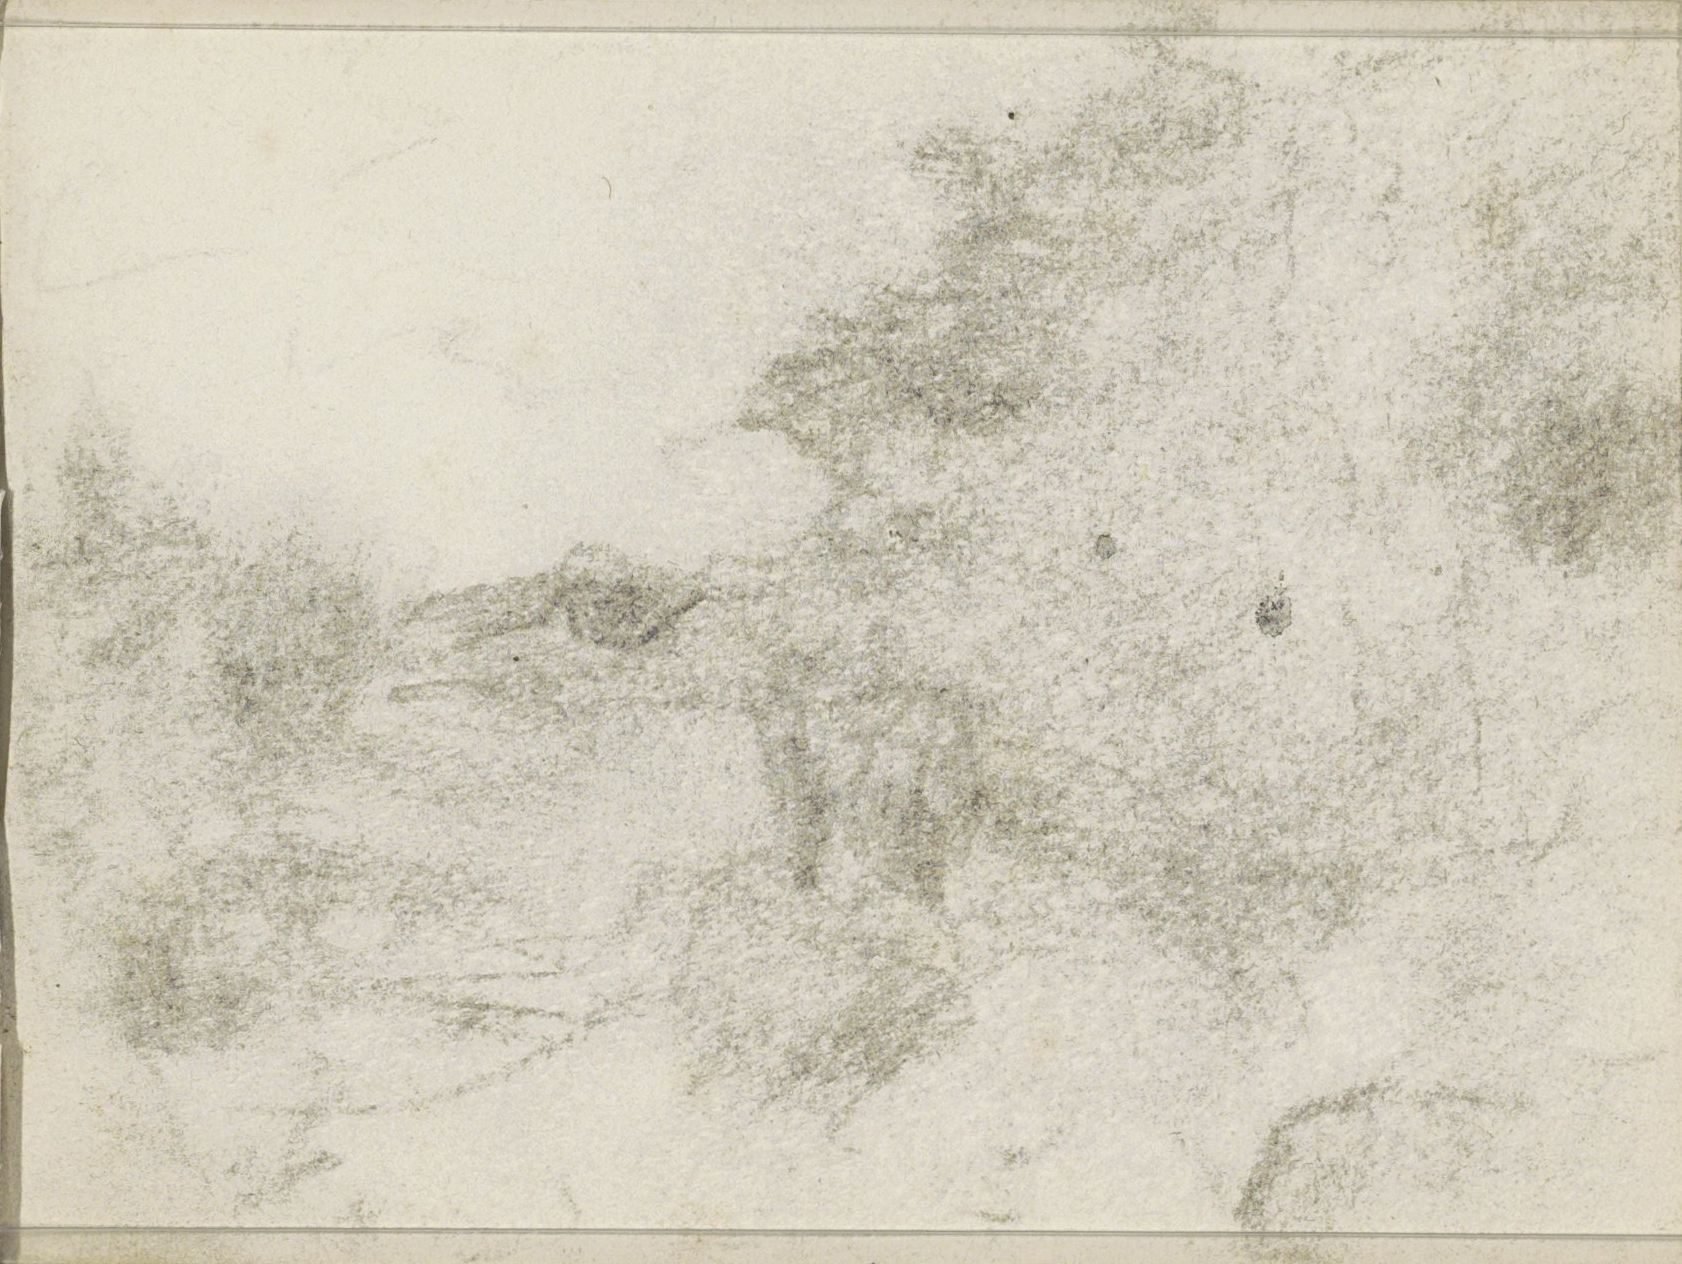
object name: sketchbook leaf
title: Studie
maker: anton mauve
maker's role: draughtsman, painter, print maker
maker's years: 1838-1888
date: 1881-1888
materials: chalk, paper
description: Blad 18 recto uit een schetsboek met 29 bladen.